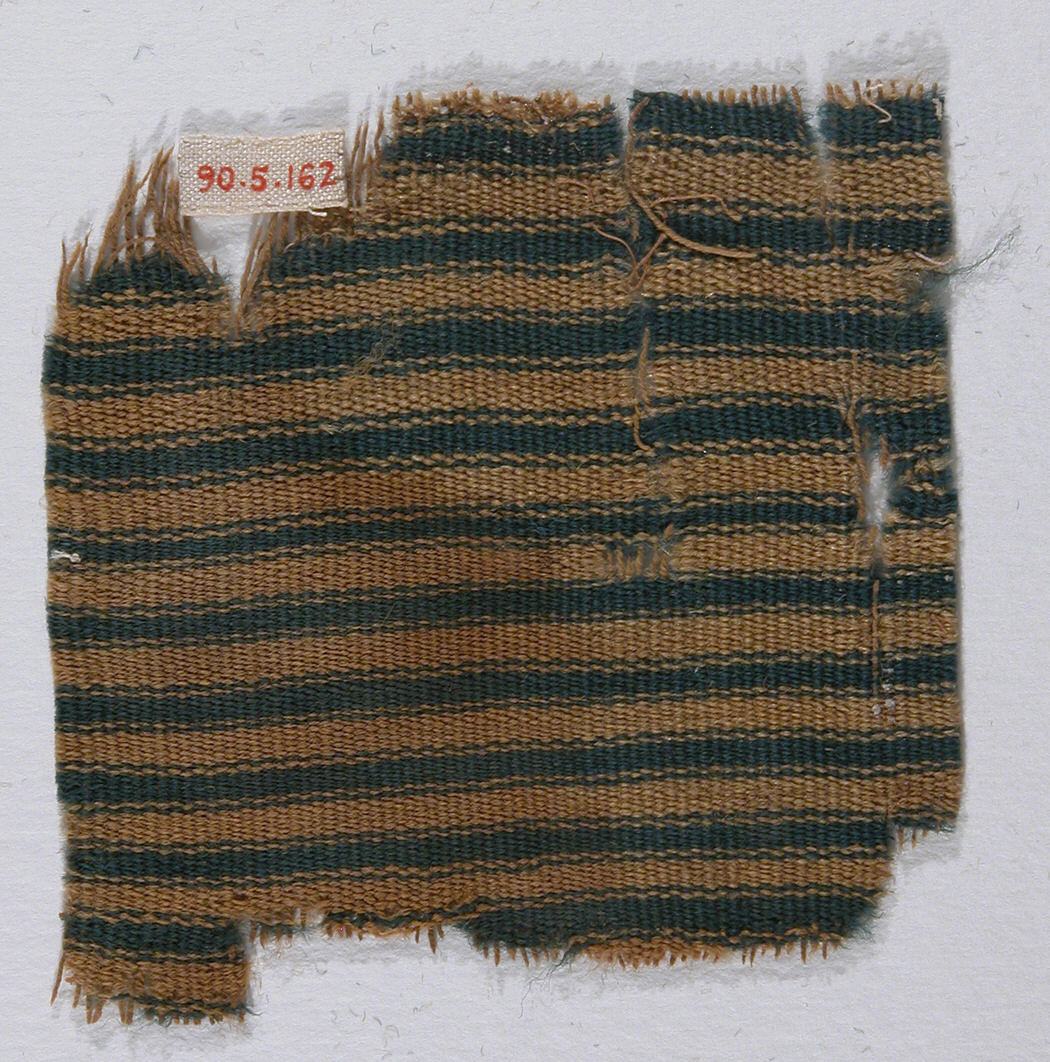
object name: textile fragment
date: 401-600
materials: wool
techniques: weave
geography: egypt